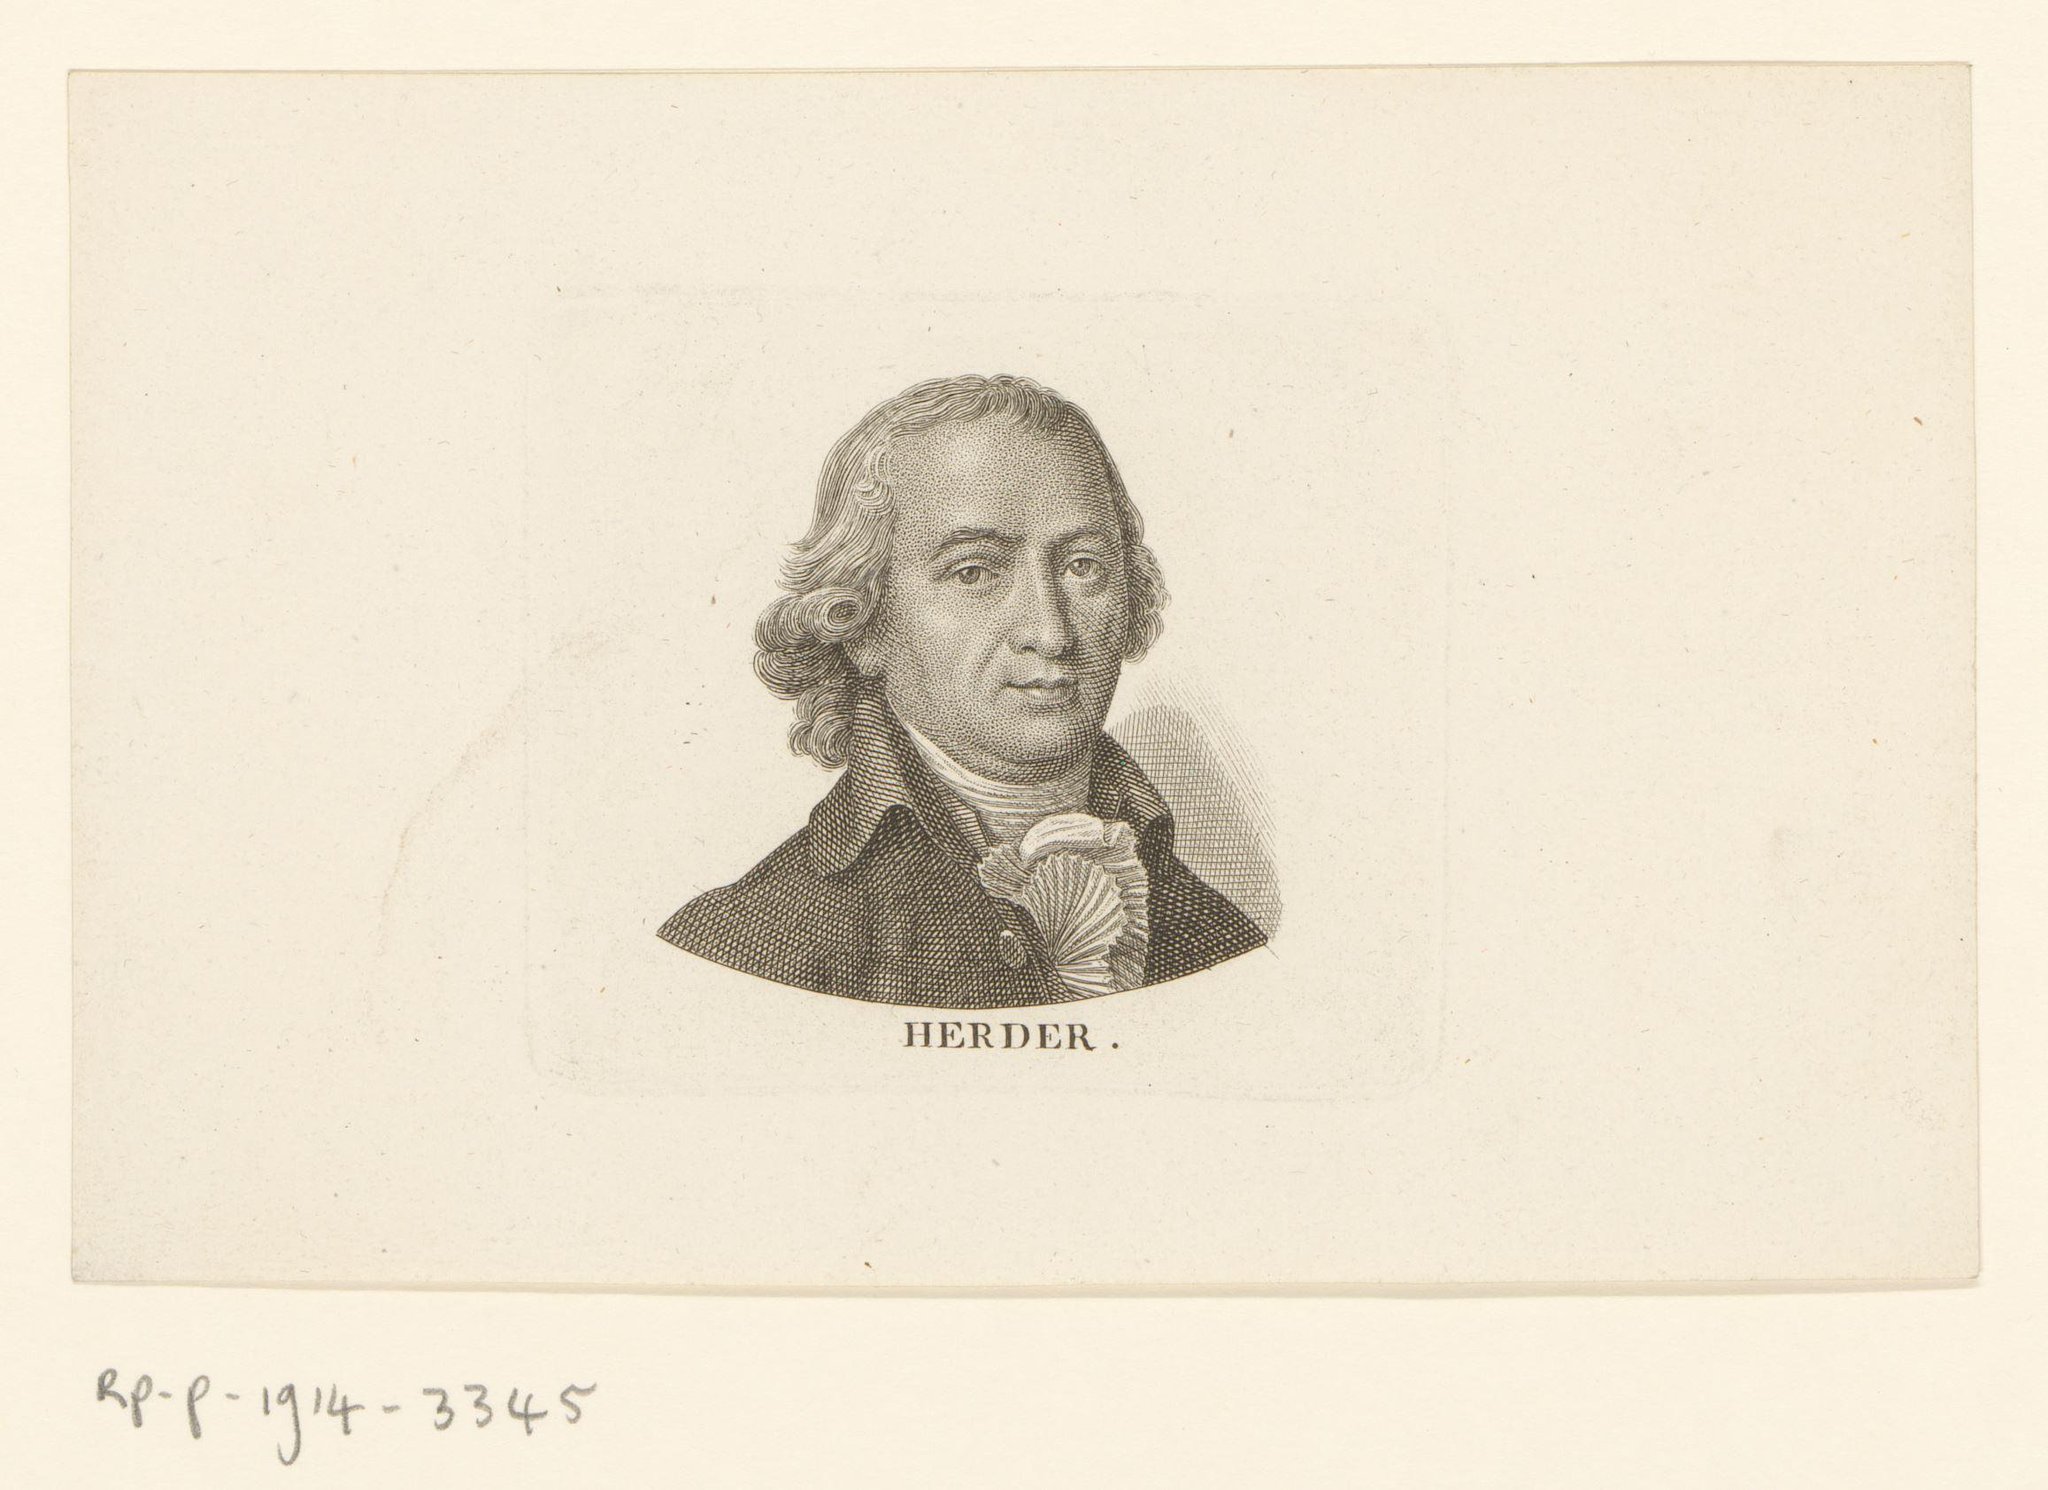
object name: print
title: Portret van Johann Gottfried von Herder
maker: ernst ludwig riepenhausen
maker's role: print maker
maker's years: 1765-1840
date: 1775-1840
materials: paper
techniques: engraving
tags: historical persons, writer, poet, author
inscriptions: collector's mark: Lugt 2228